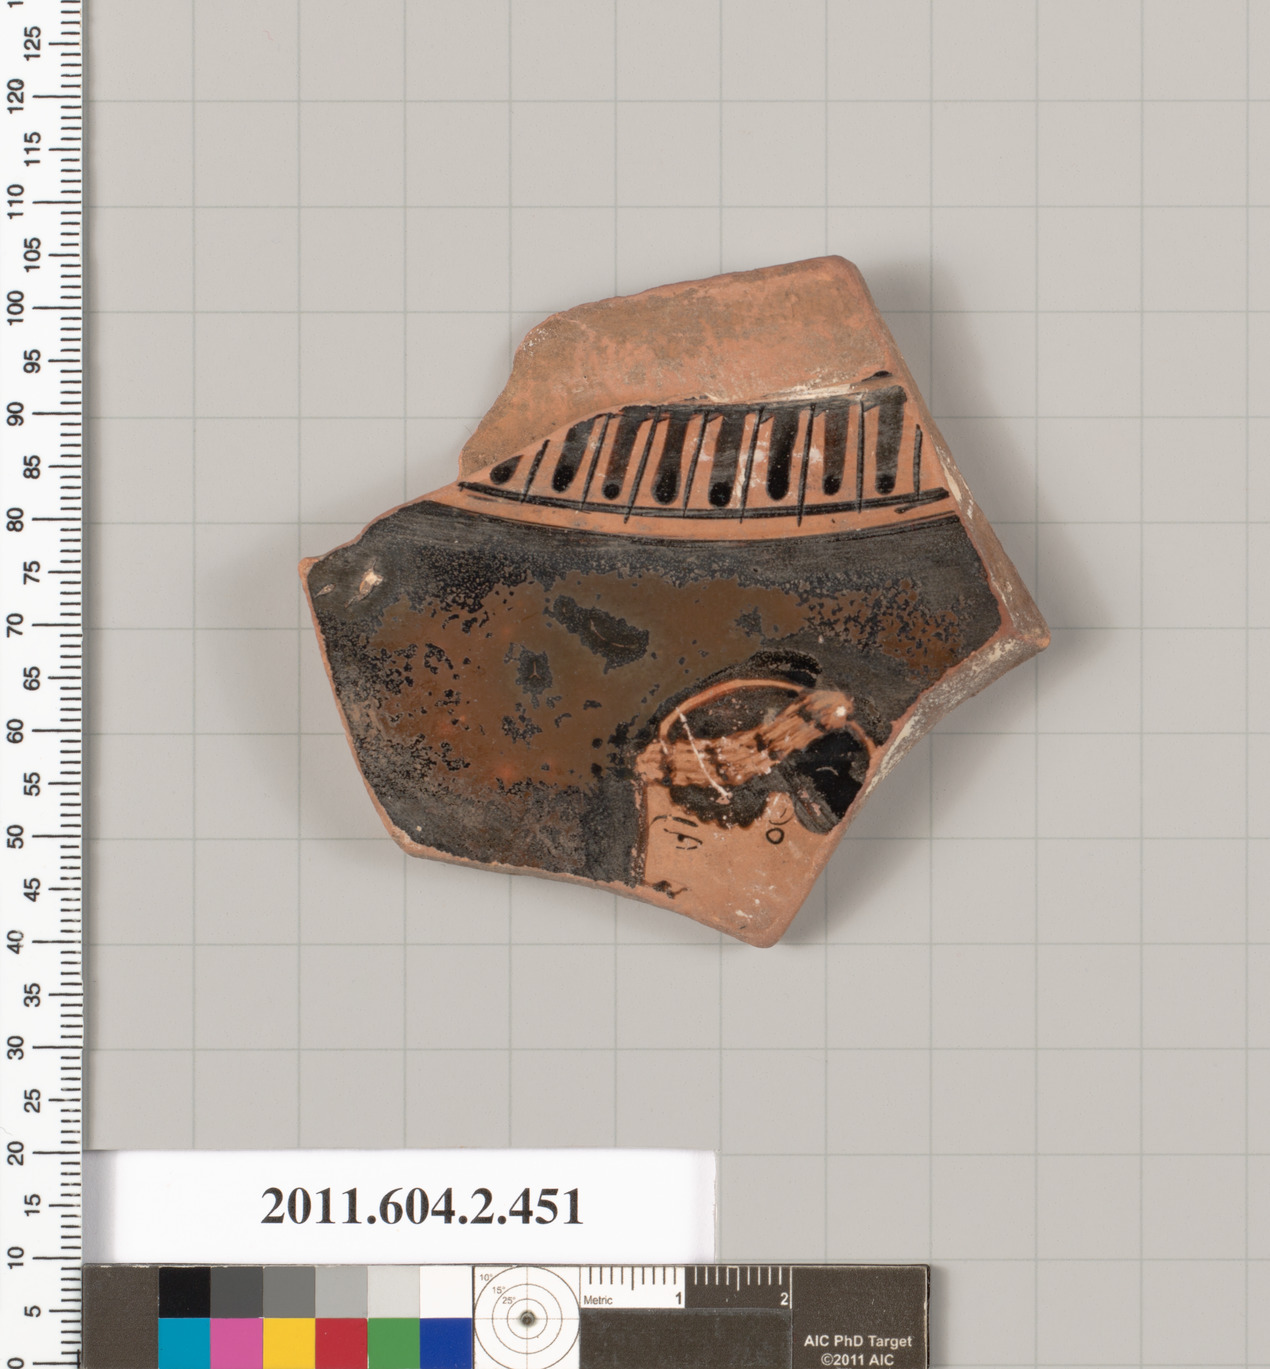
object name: column krater fragment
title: Terracotta fragment of a column-krater (bowl for mixing wine and water)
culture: greek, attic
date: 450-430 BCE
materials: terracotta